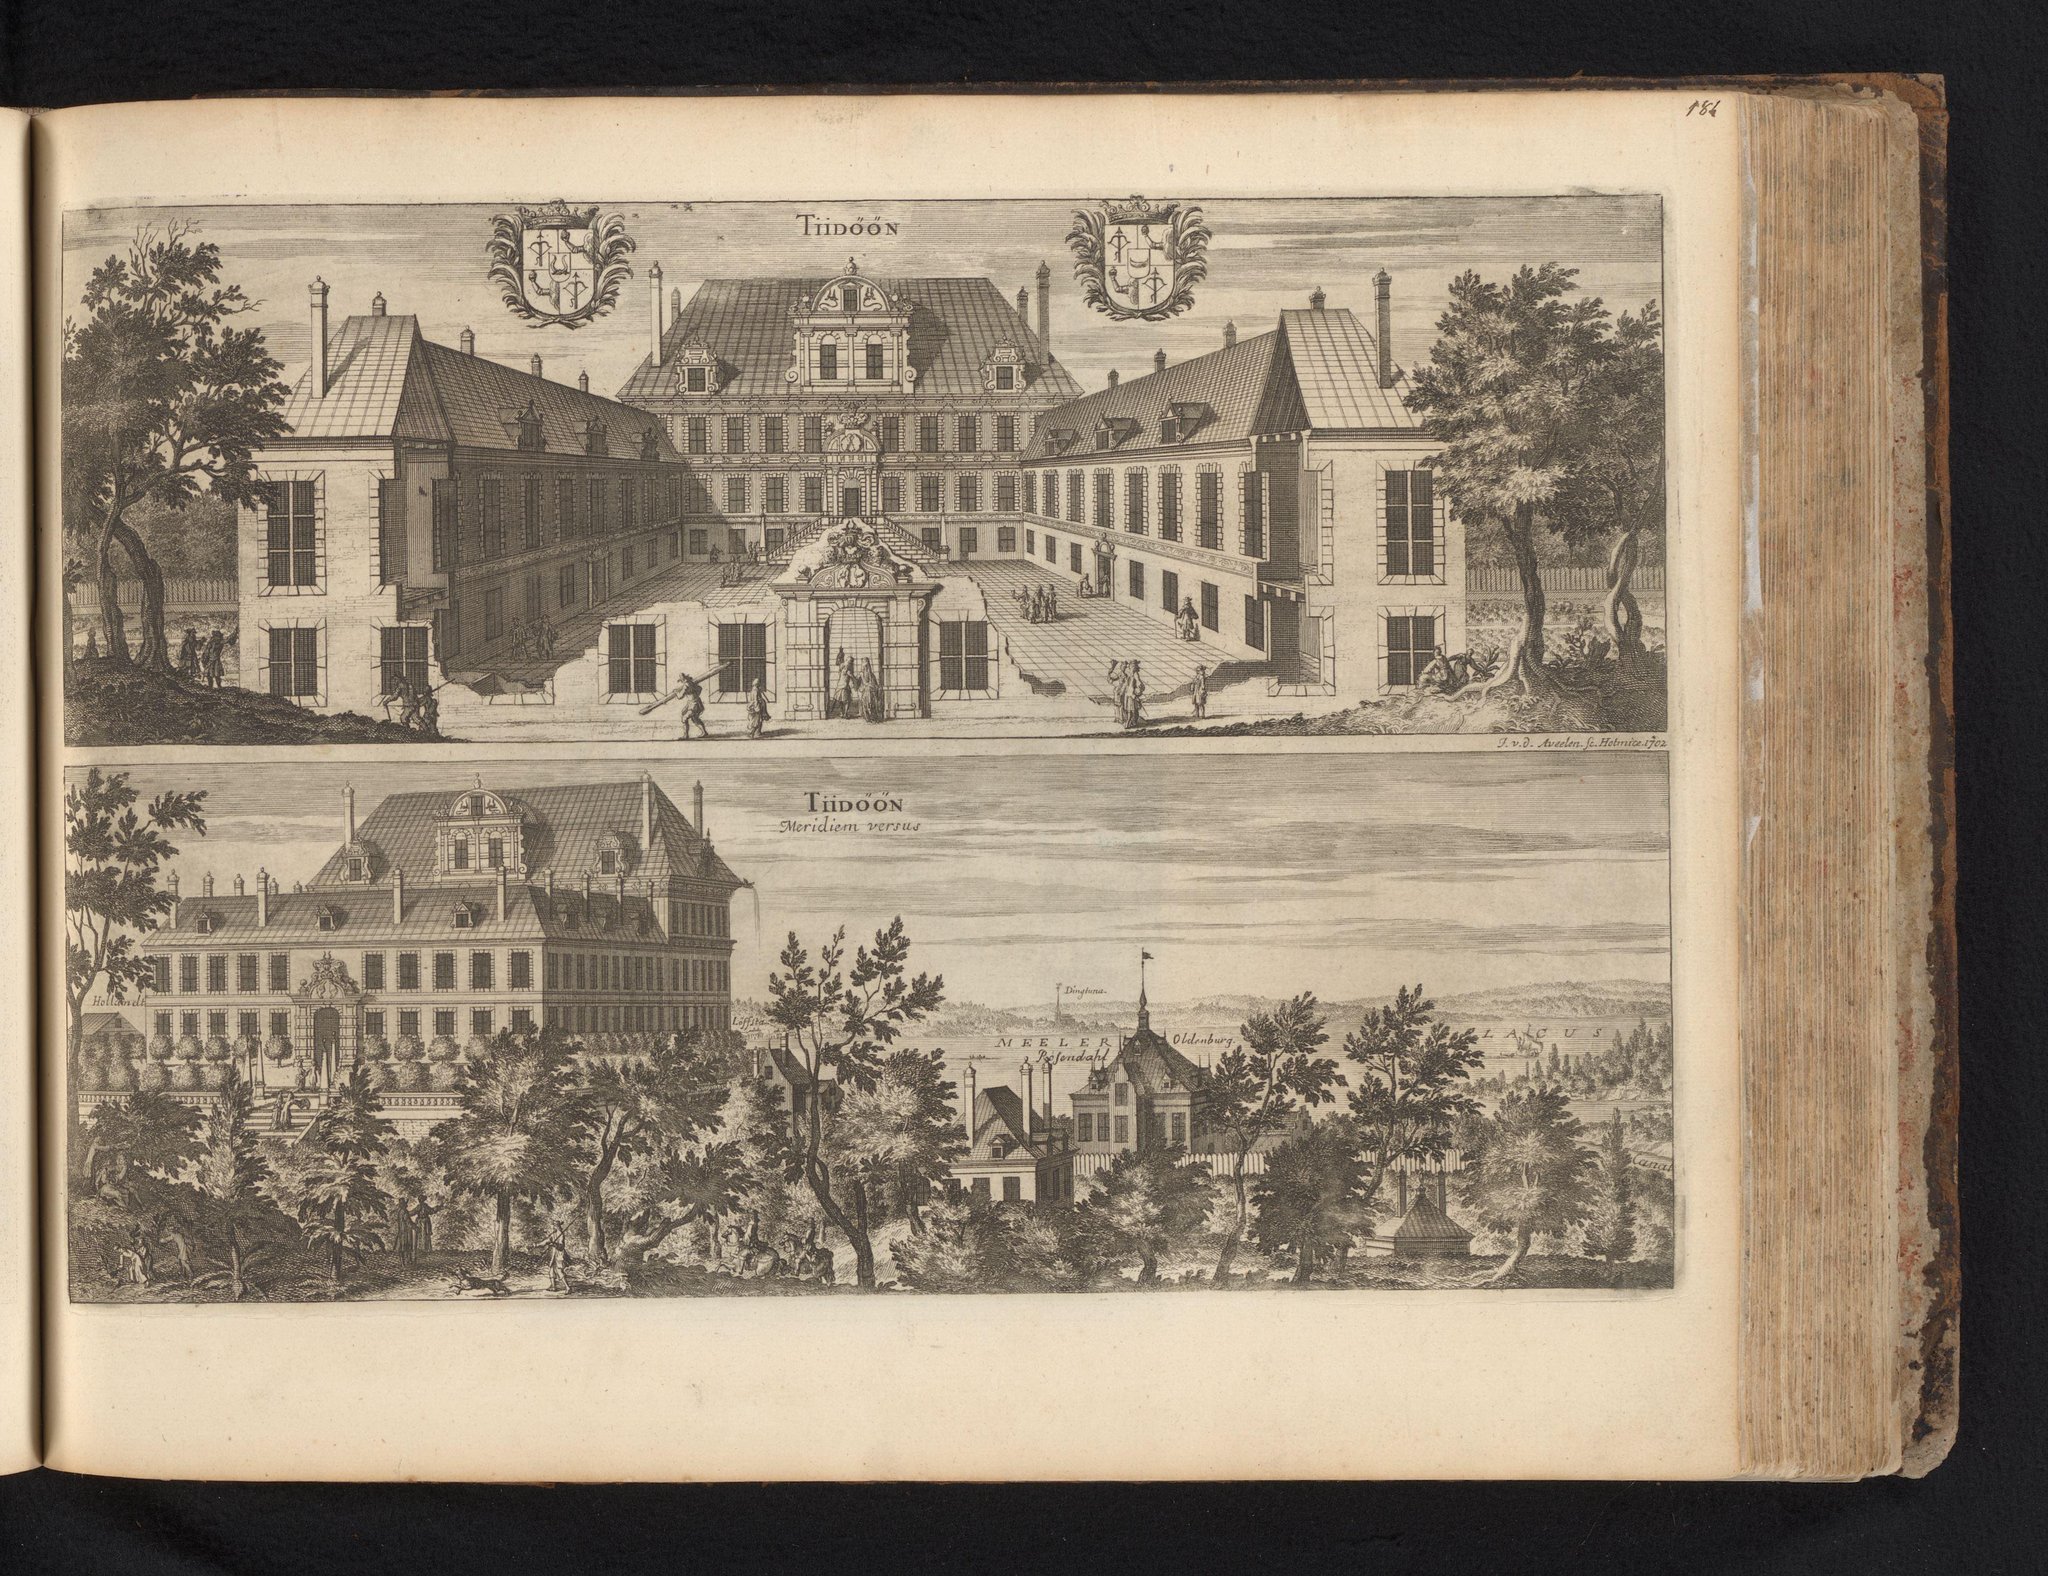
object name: print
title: Gezicht op slot Tidö, ook vanuit het zuiden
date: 1702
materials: paper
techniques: etching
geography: stockholm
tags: war and peace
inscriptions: date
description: Kungliga Biblioteket, 'Suecia': http://www.kb.se/samlingarna/Kartor-bilder/Suecia-antiqua/ (geraadpleegd november 2016).